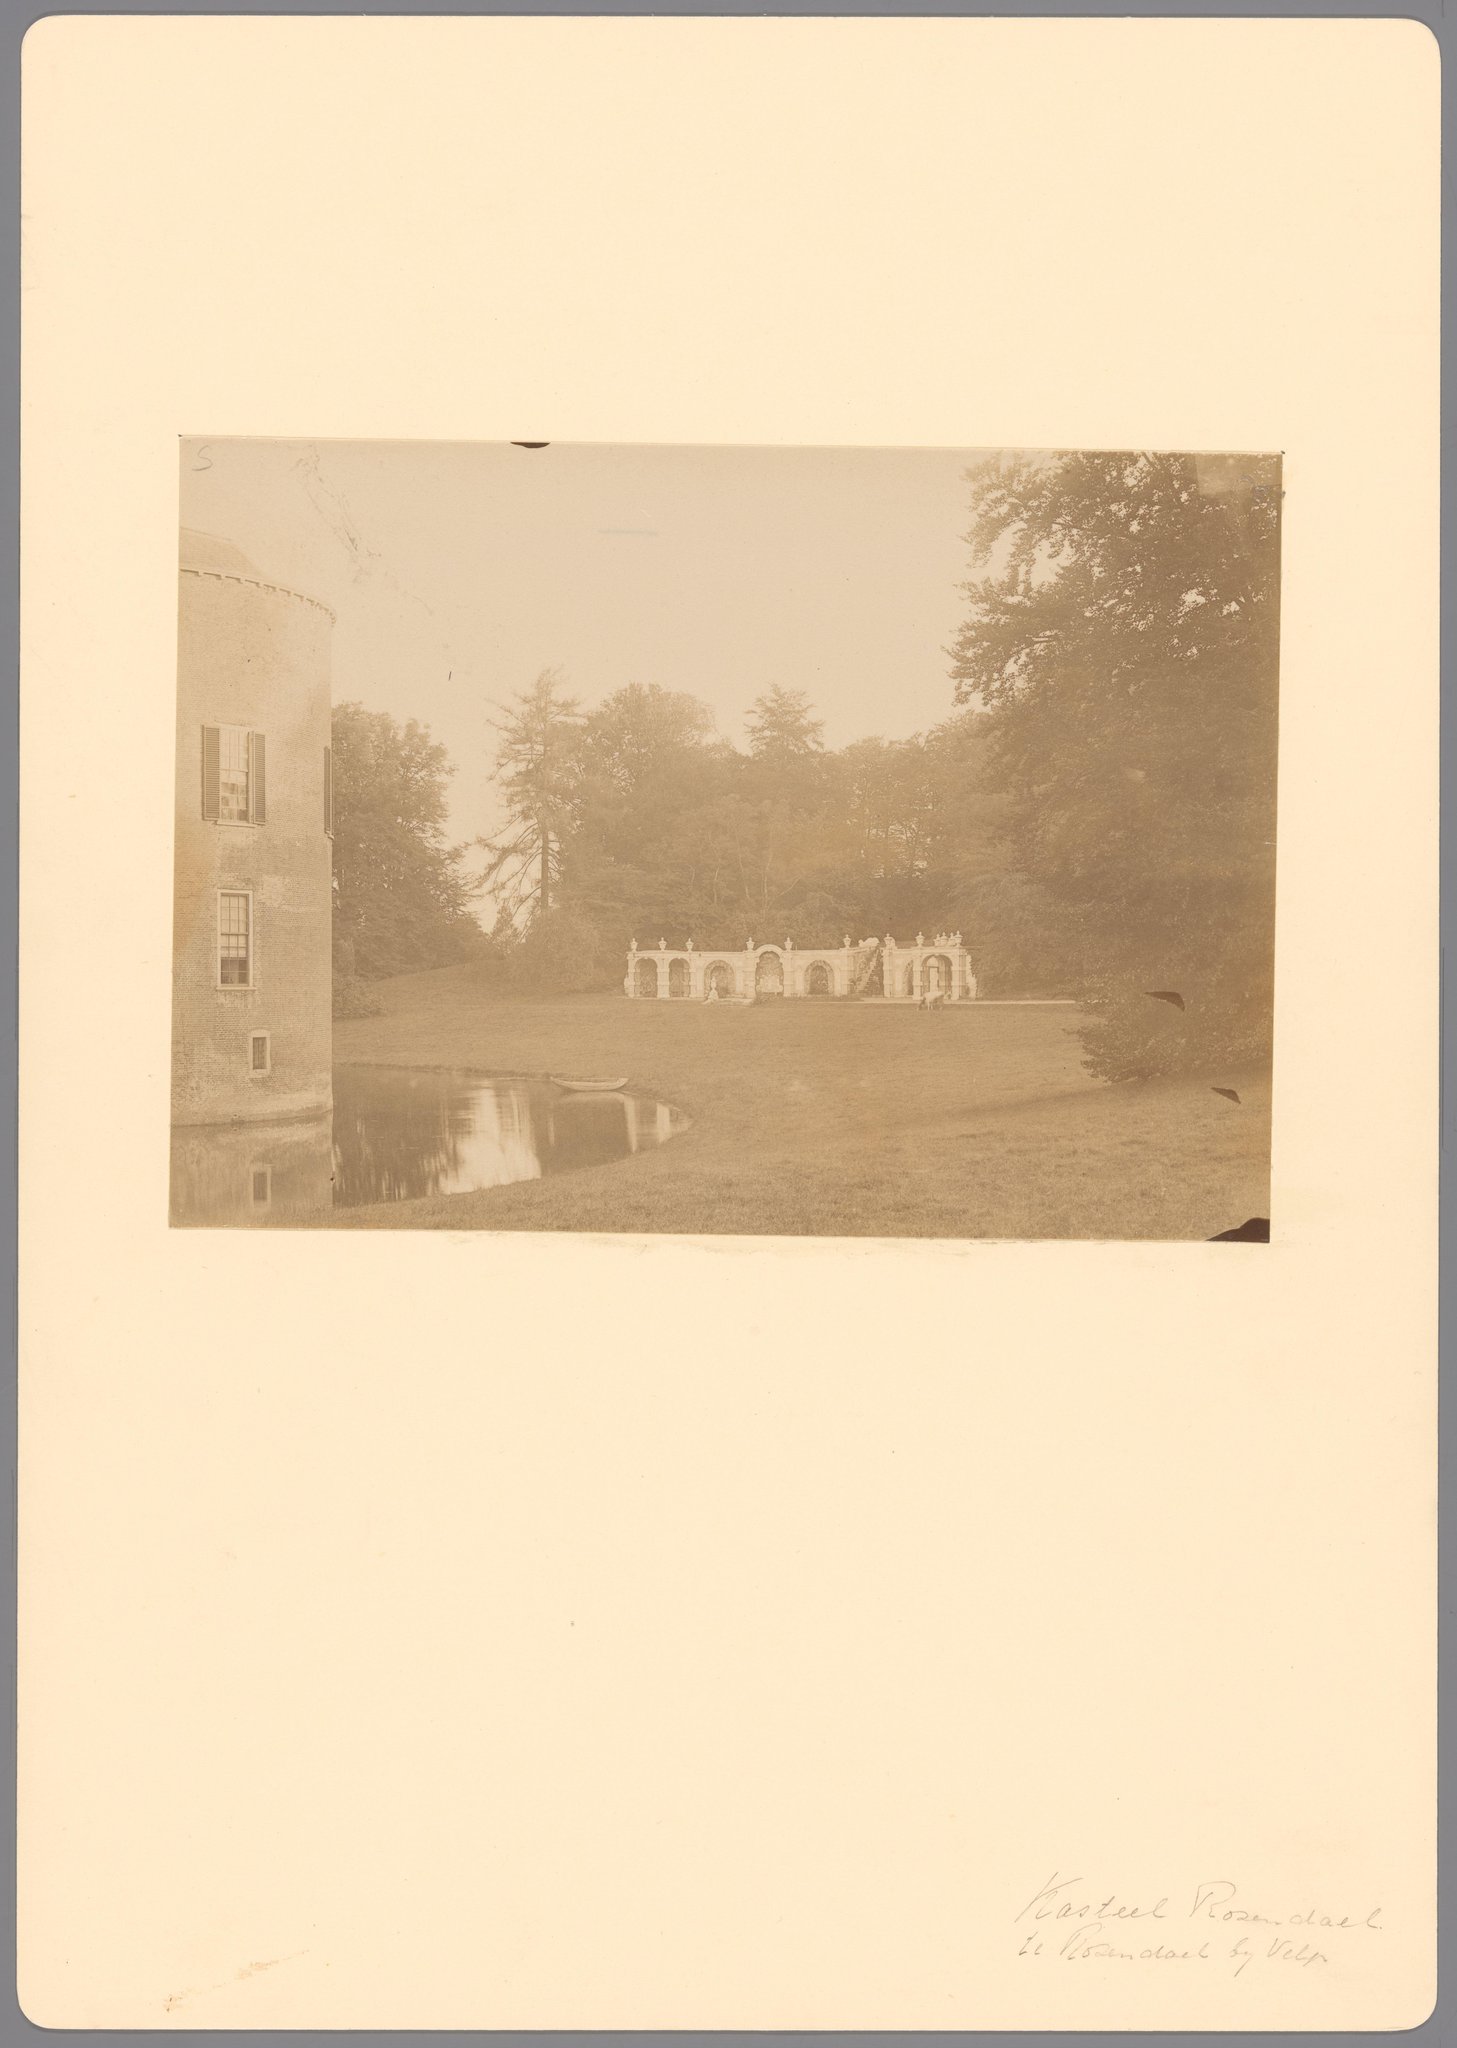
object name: photograph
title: Gezicht op de tuin bij Kasteel Rozendael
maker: anoniem (monumentenzorg)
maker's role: fotograaf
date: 1890-1920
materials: cardboard, photographic support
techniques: albumen print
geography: rozendaal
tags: castle, landscape with tower or castle, garden buildings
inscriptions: annotation: ‘S/ Kasteel Rozendael te Rozendael bij Velp’